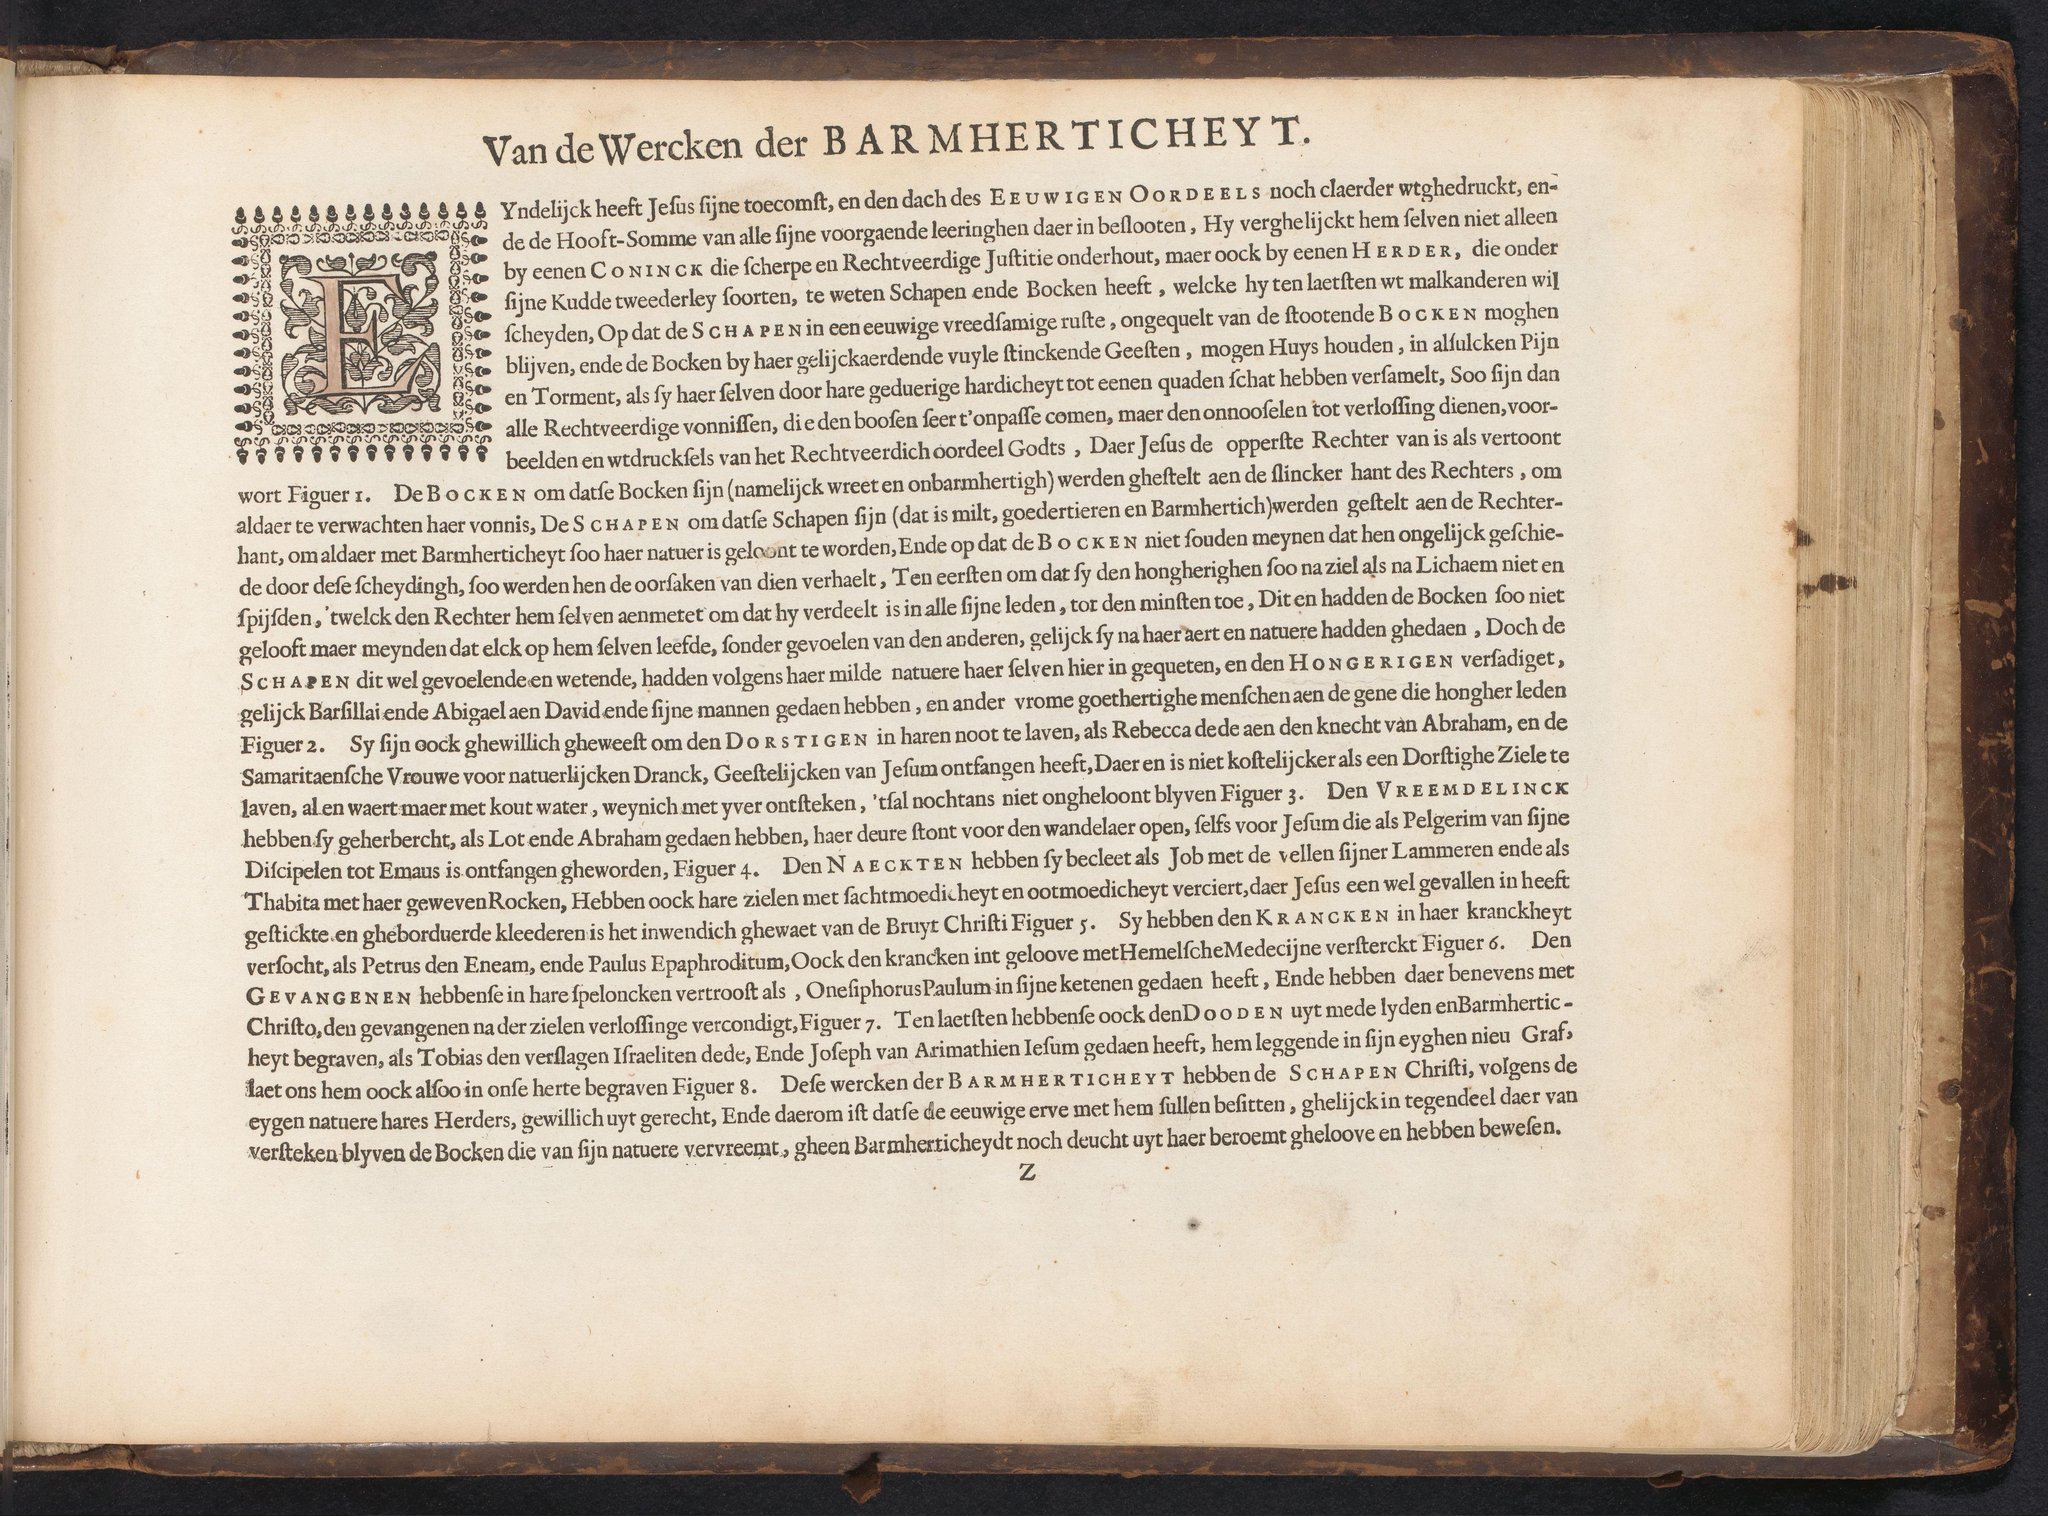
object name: album leaf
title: Den Grooten Figuer-Bibel (...)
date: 1646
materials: paper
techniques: hand coloring, letterpress printing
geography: alkmaar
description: Tekstblad bij een serie prenten over de zeven werken van barmhartigheid. Linksboven initiaal E. Dit blad maakt deel uit van een album.